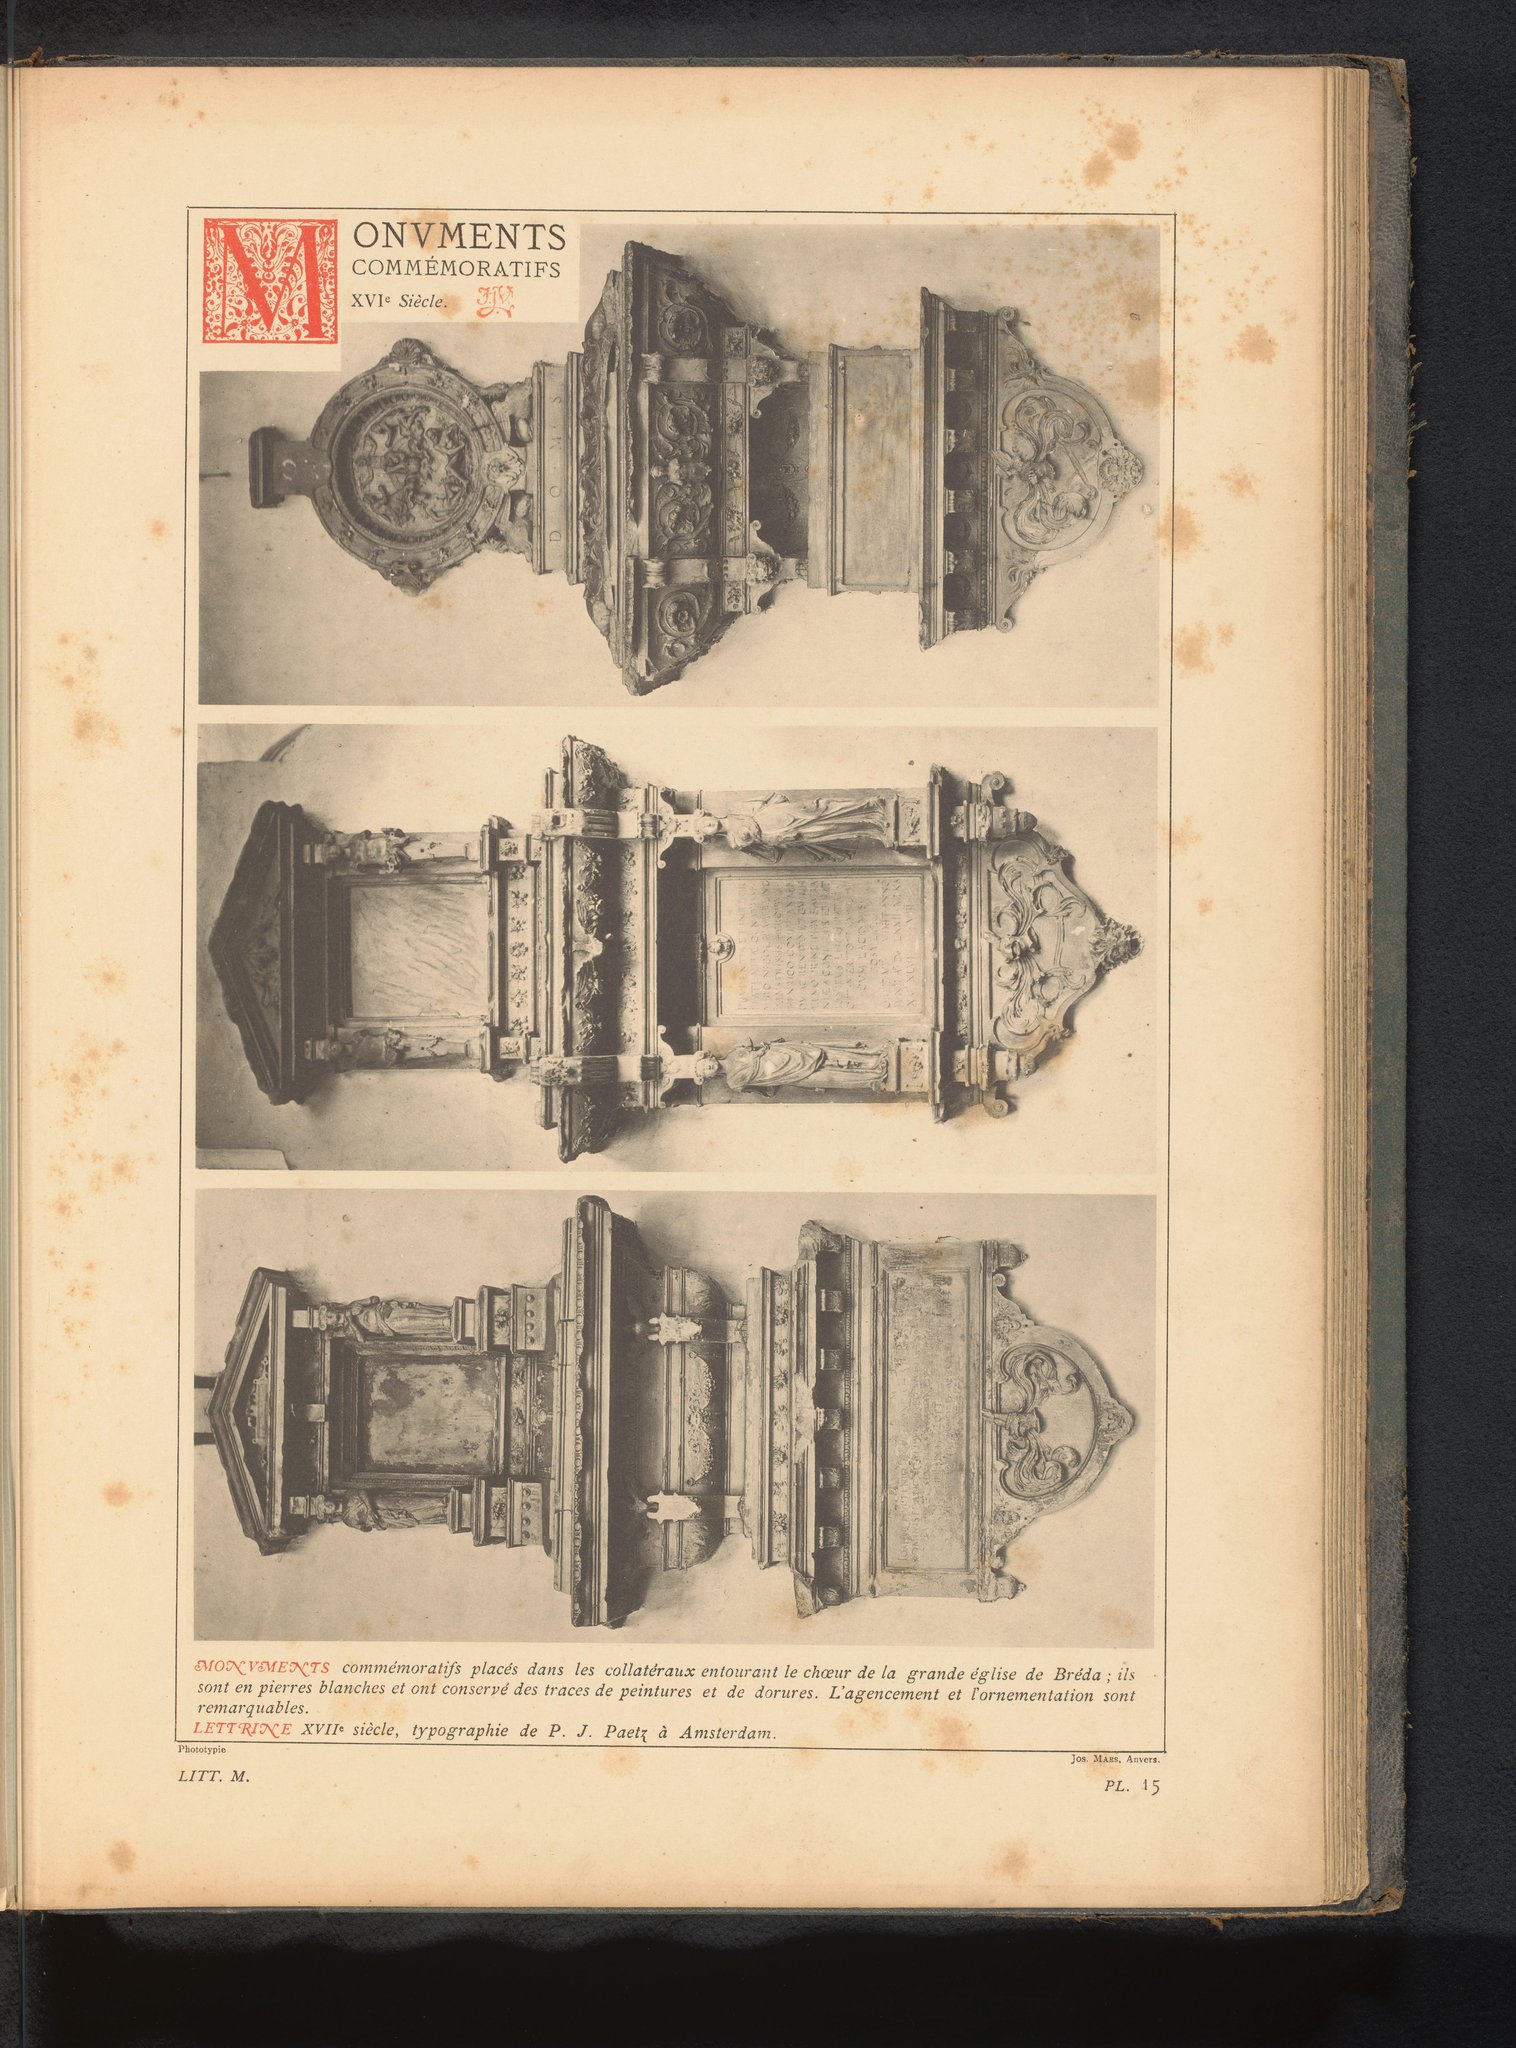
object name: page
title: Monuments Commémoratifs, XVIe Siècle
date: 1875-1880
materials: paper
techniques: photograph, photolithography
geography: amsterdam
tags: the place of worship and its equipment ~ christian churches, commemoration, jubilee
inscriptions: inscription: ‘MONUMENTS commémoratifs placés (...)’, monogram: ‘JJvY’, inscription: ‘LITT. M. - PL. 15’